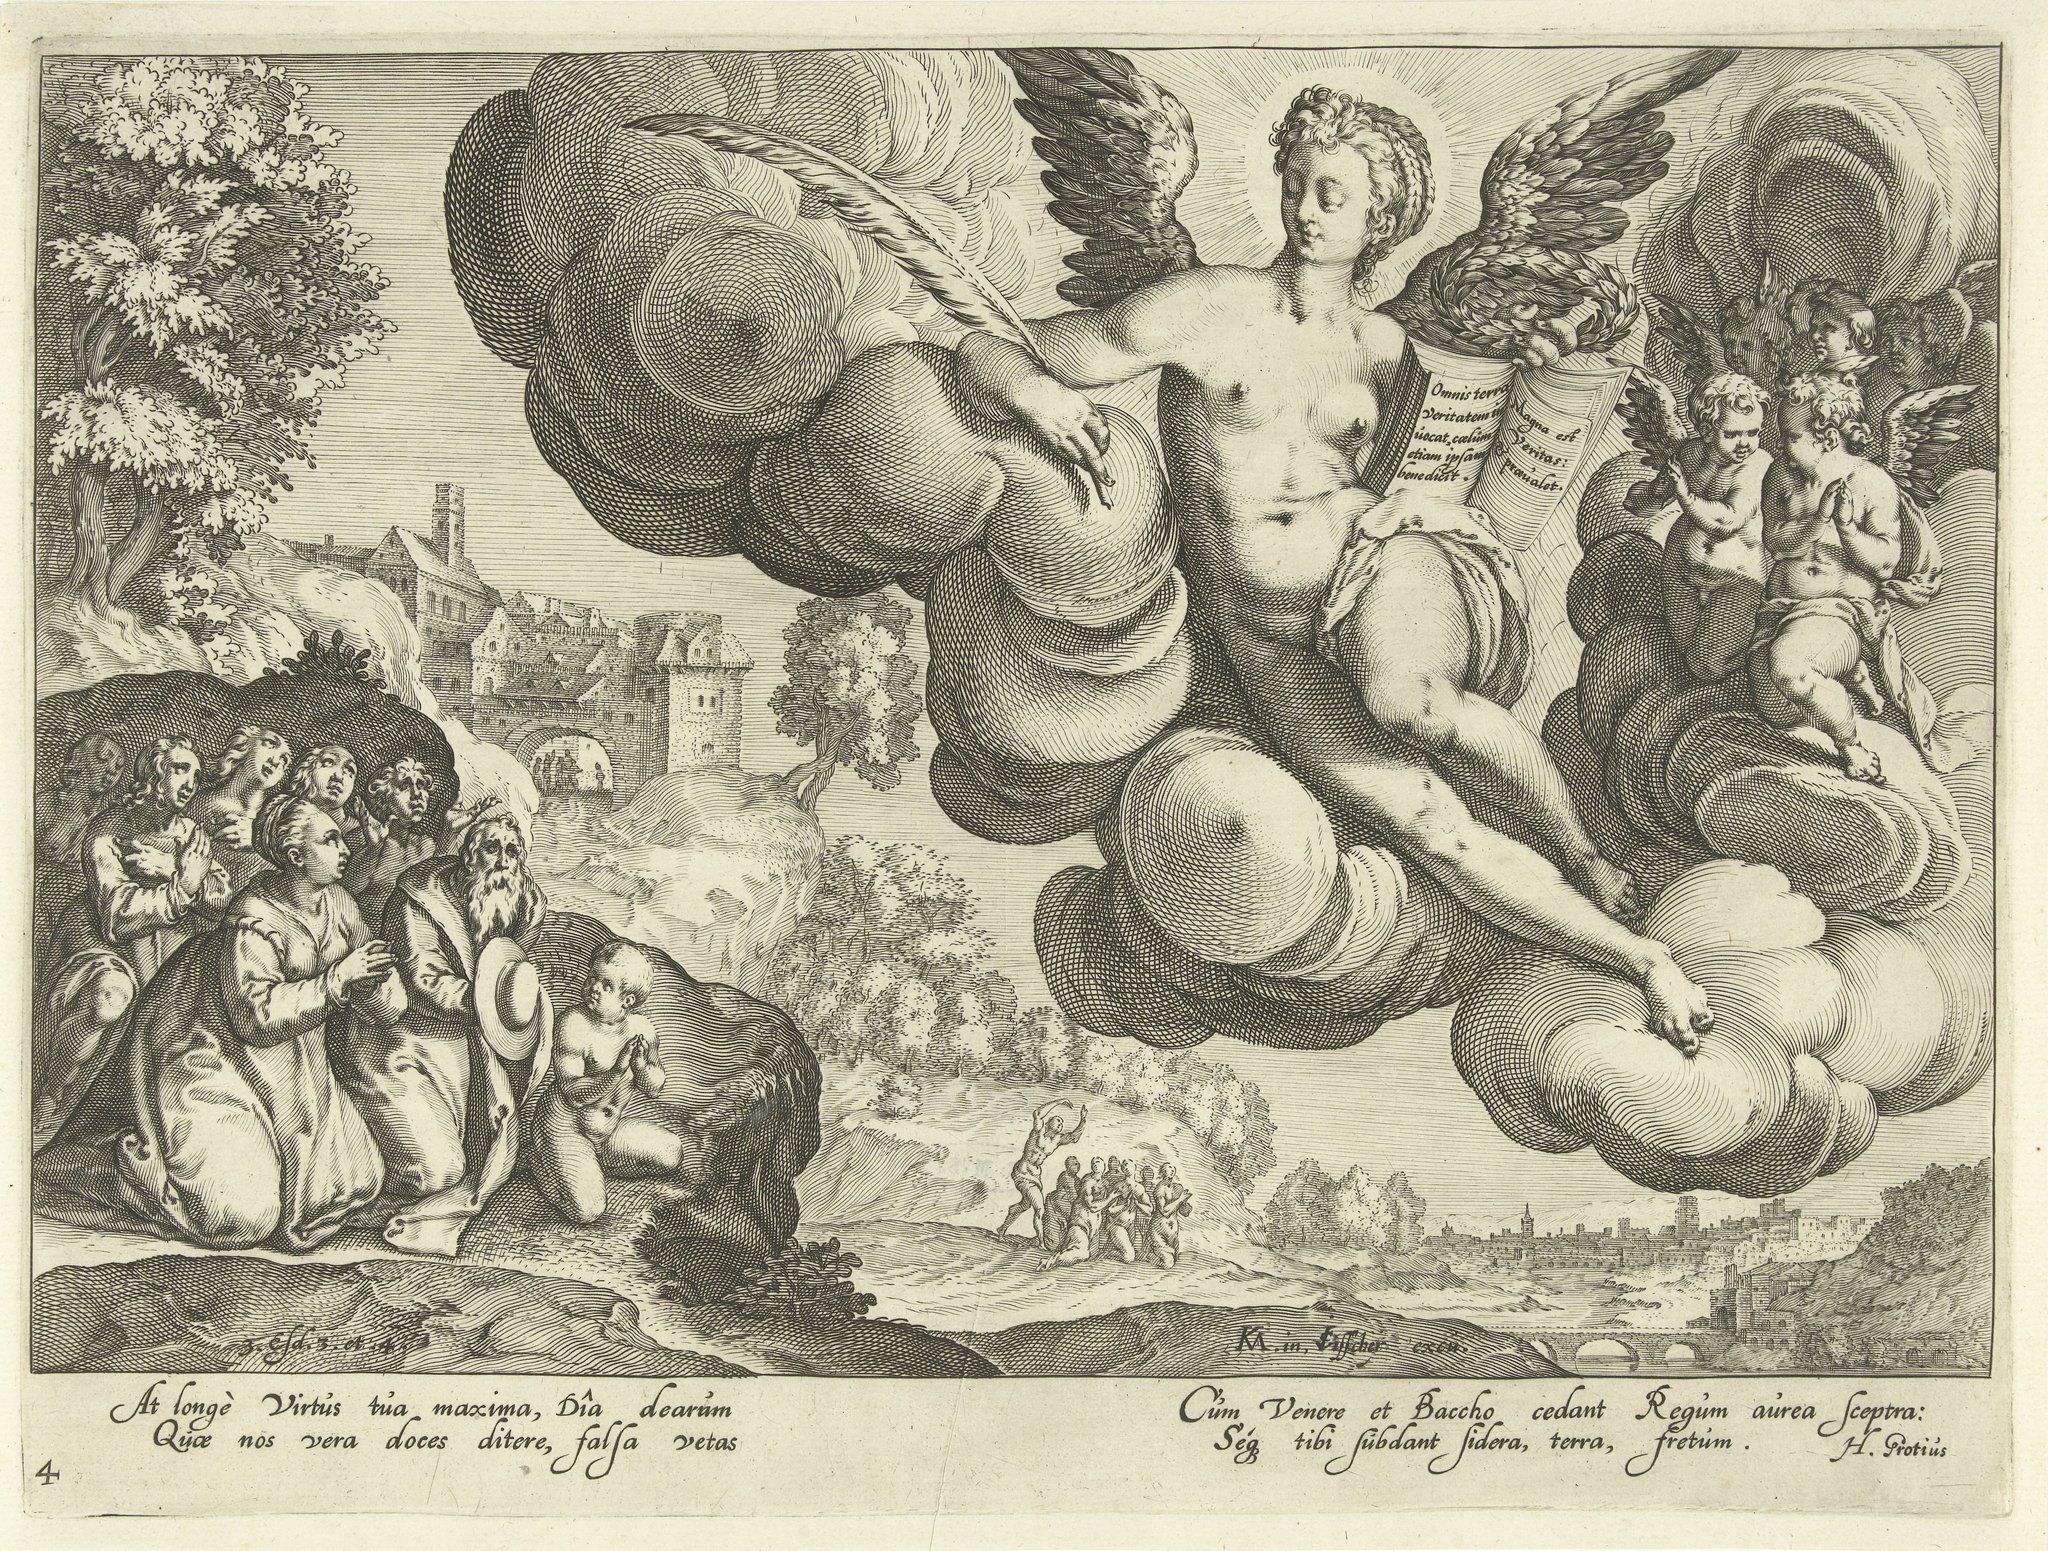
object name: print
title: Scènes uit het apocriefe bijbelboek 3 Esdras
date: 1595-1596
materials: paper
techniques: engraving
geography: netherlands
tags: truth; 'verità' (ripa), the first guardsman says (writes) that wine is the strongest of all things ~ contest of the three guardsmen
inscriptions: collector's mark: Lugt 2228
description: De personificatie van de Waarheid zit op een wolk, naast haar een groepje engelen. Zij houdt een palmtak, een lauwerkrans en een boek vast. In een landschap knielen groepjes mensen eerbiedig voor de verschijning van de Waarheid. Voorstelling naar het boek 3 Ezra 3-4.